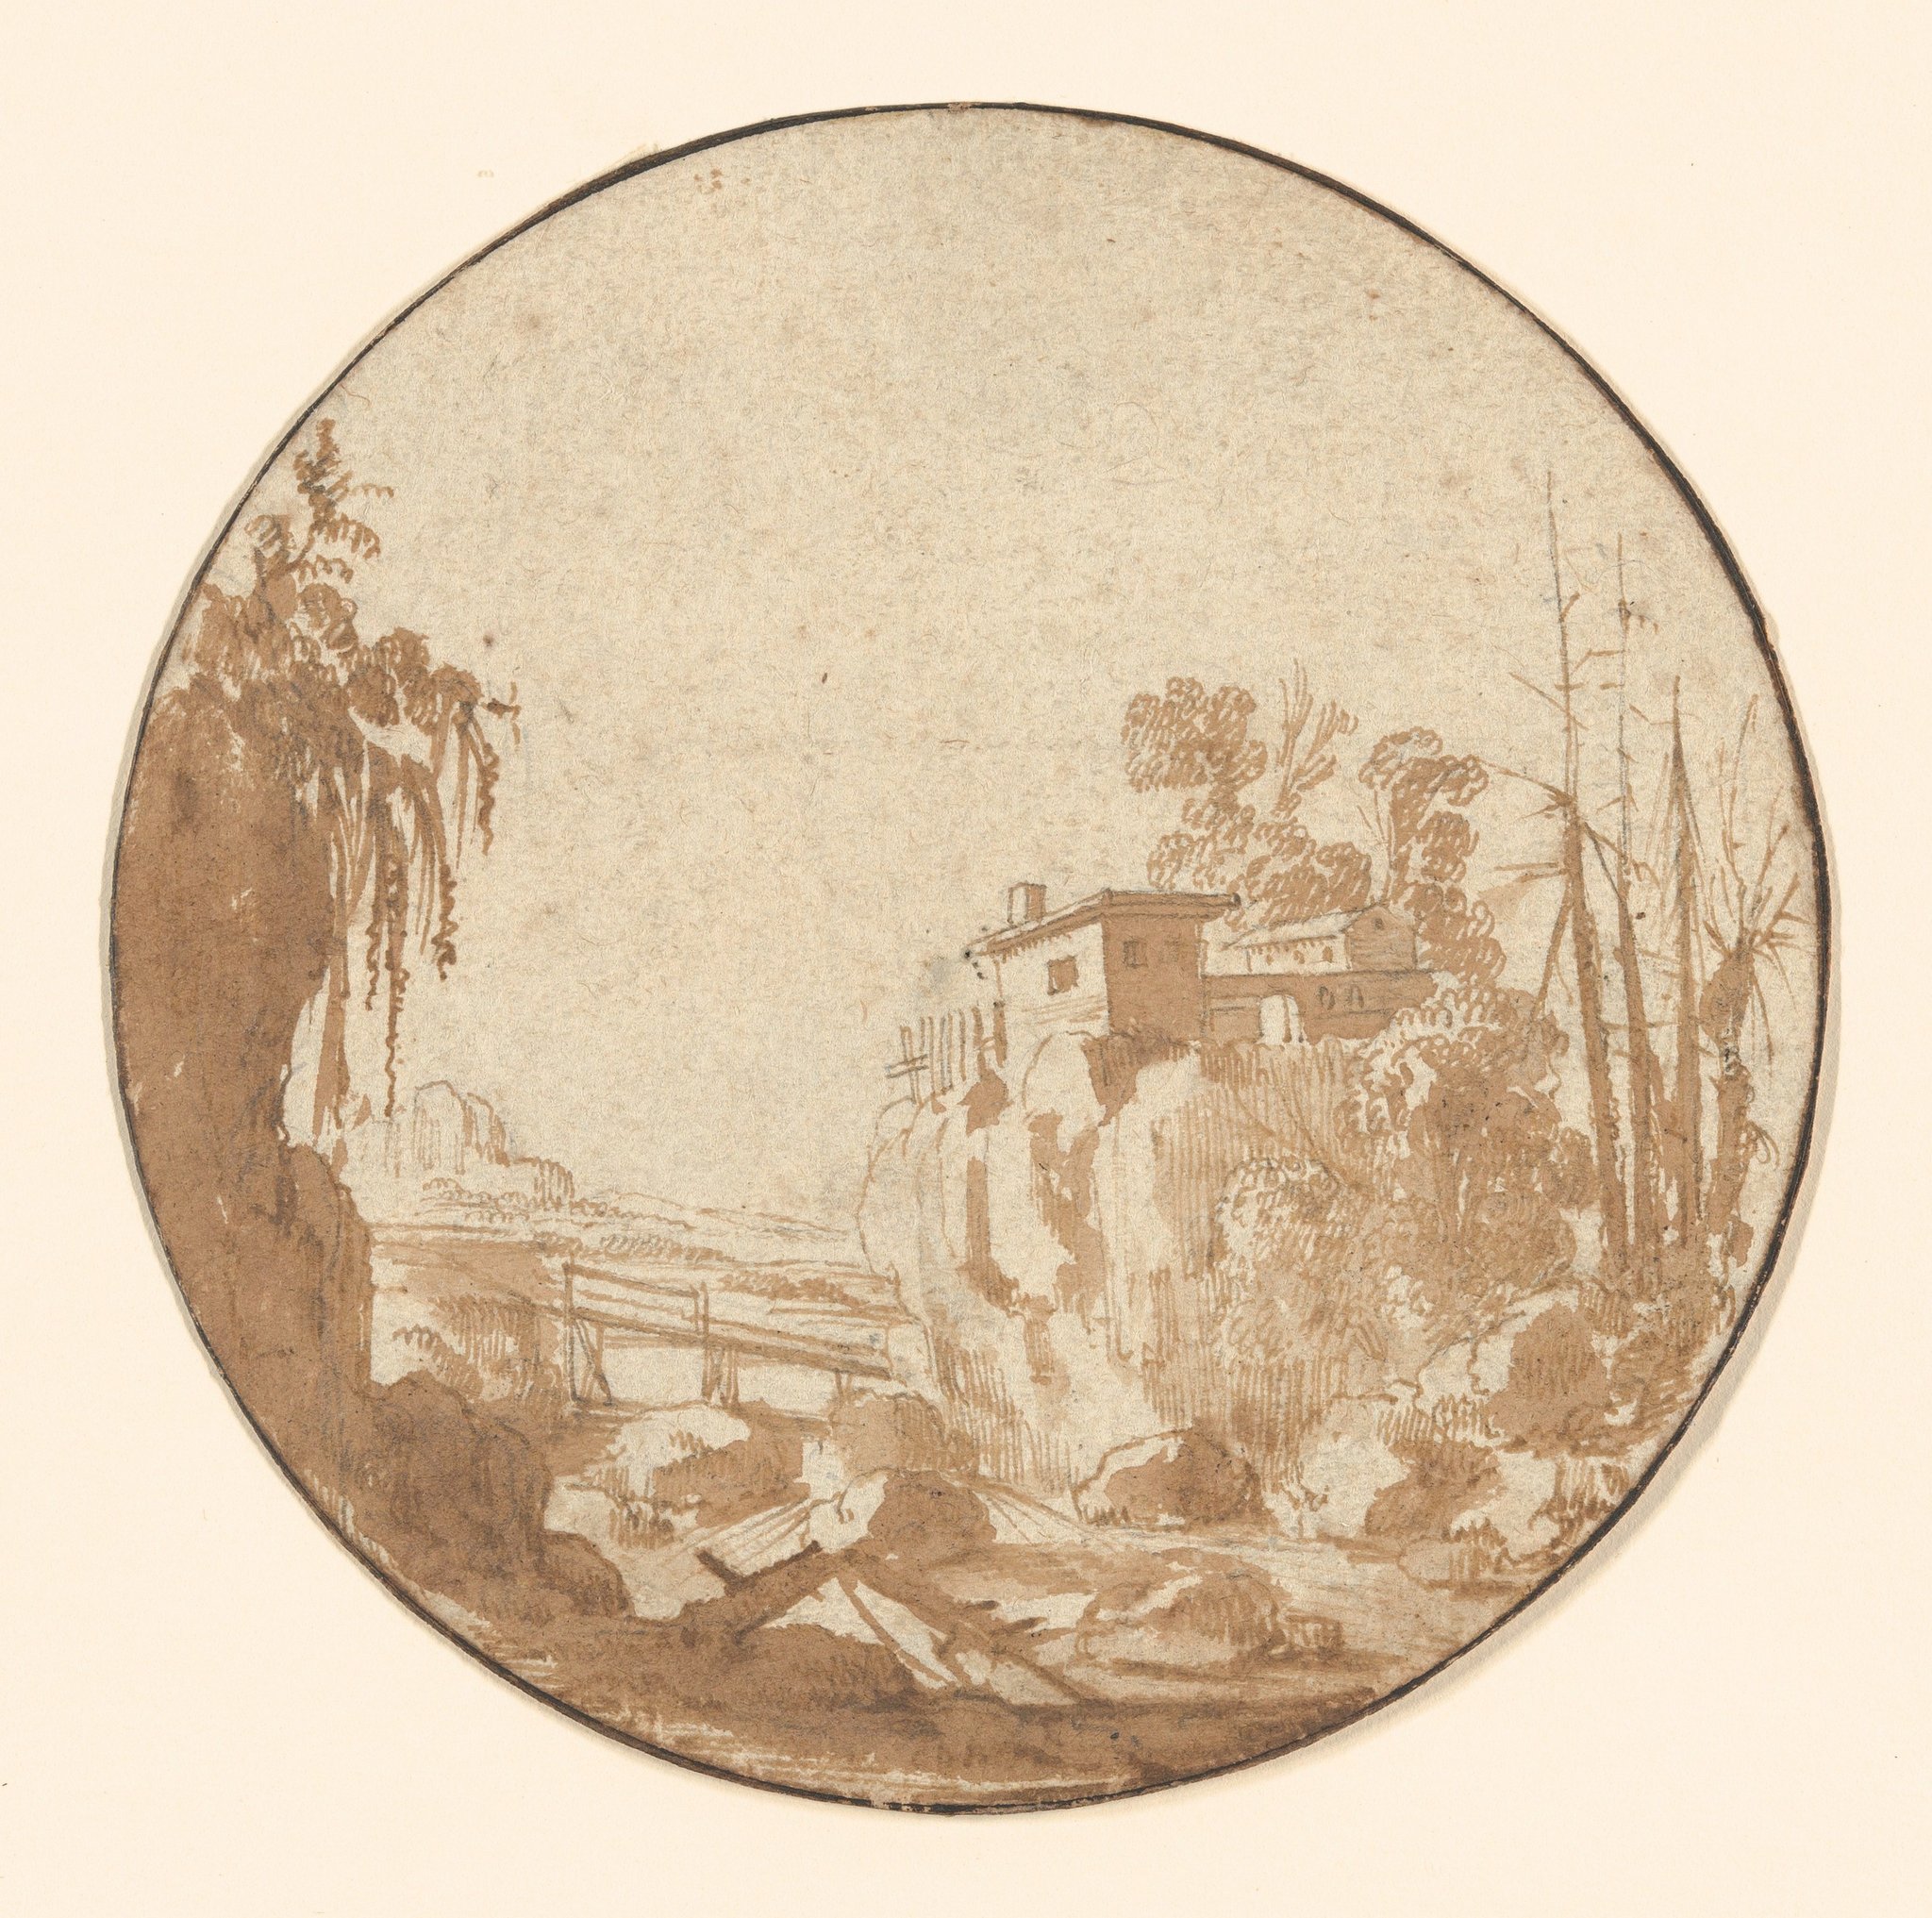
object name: drawing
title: Rocky Landscape With a Bridge and a House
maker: charles cornelisz. de hooch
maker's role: artist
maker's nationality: dutch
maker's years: 1600-1638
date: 1601-1633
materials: ink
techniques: incising, pen, transfer, wash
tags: houses,bridges,landscapes